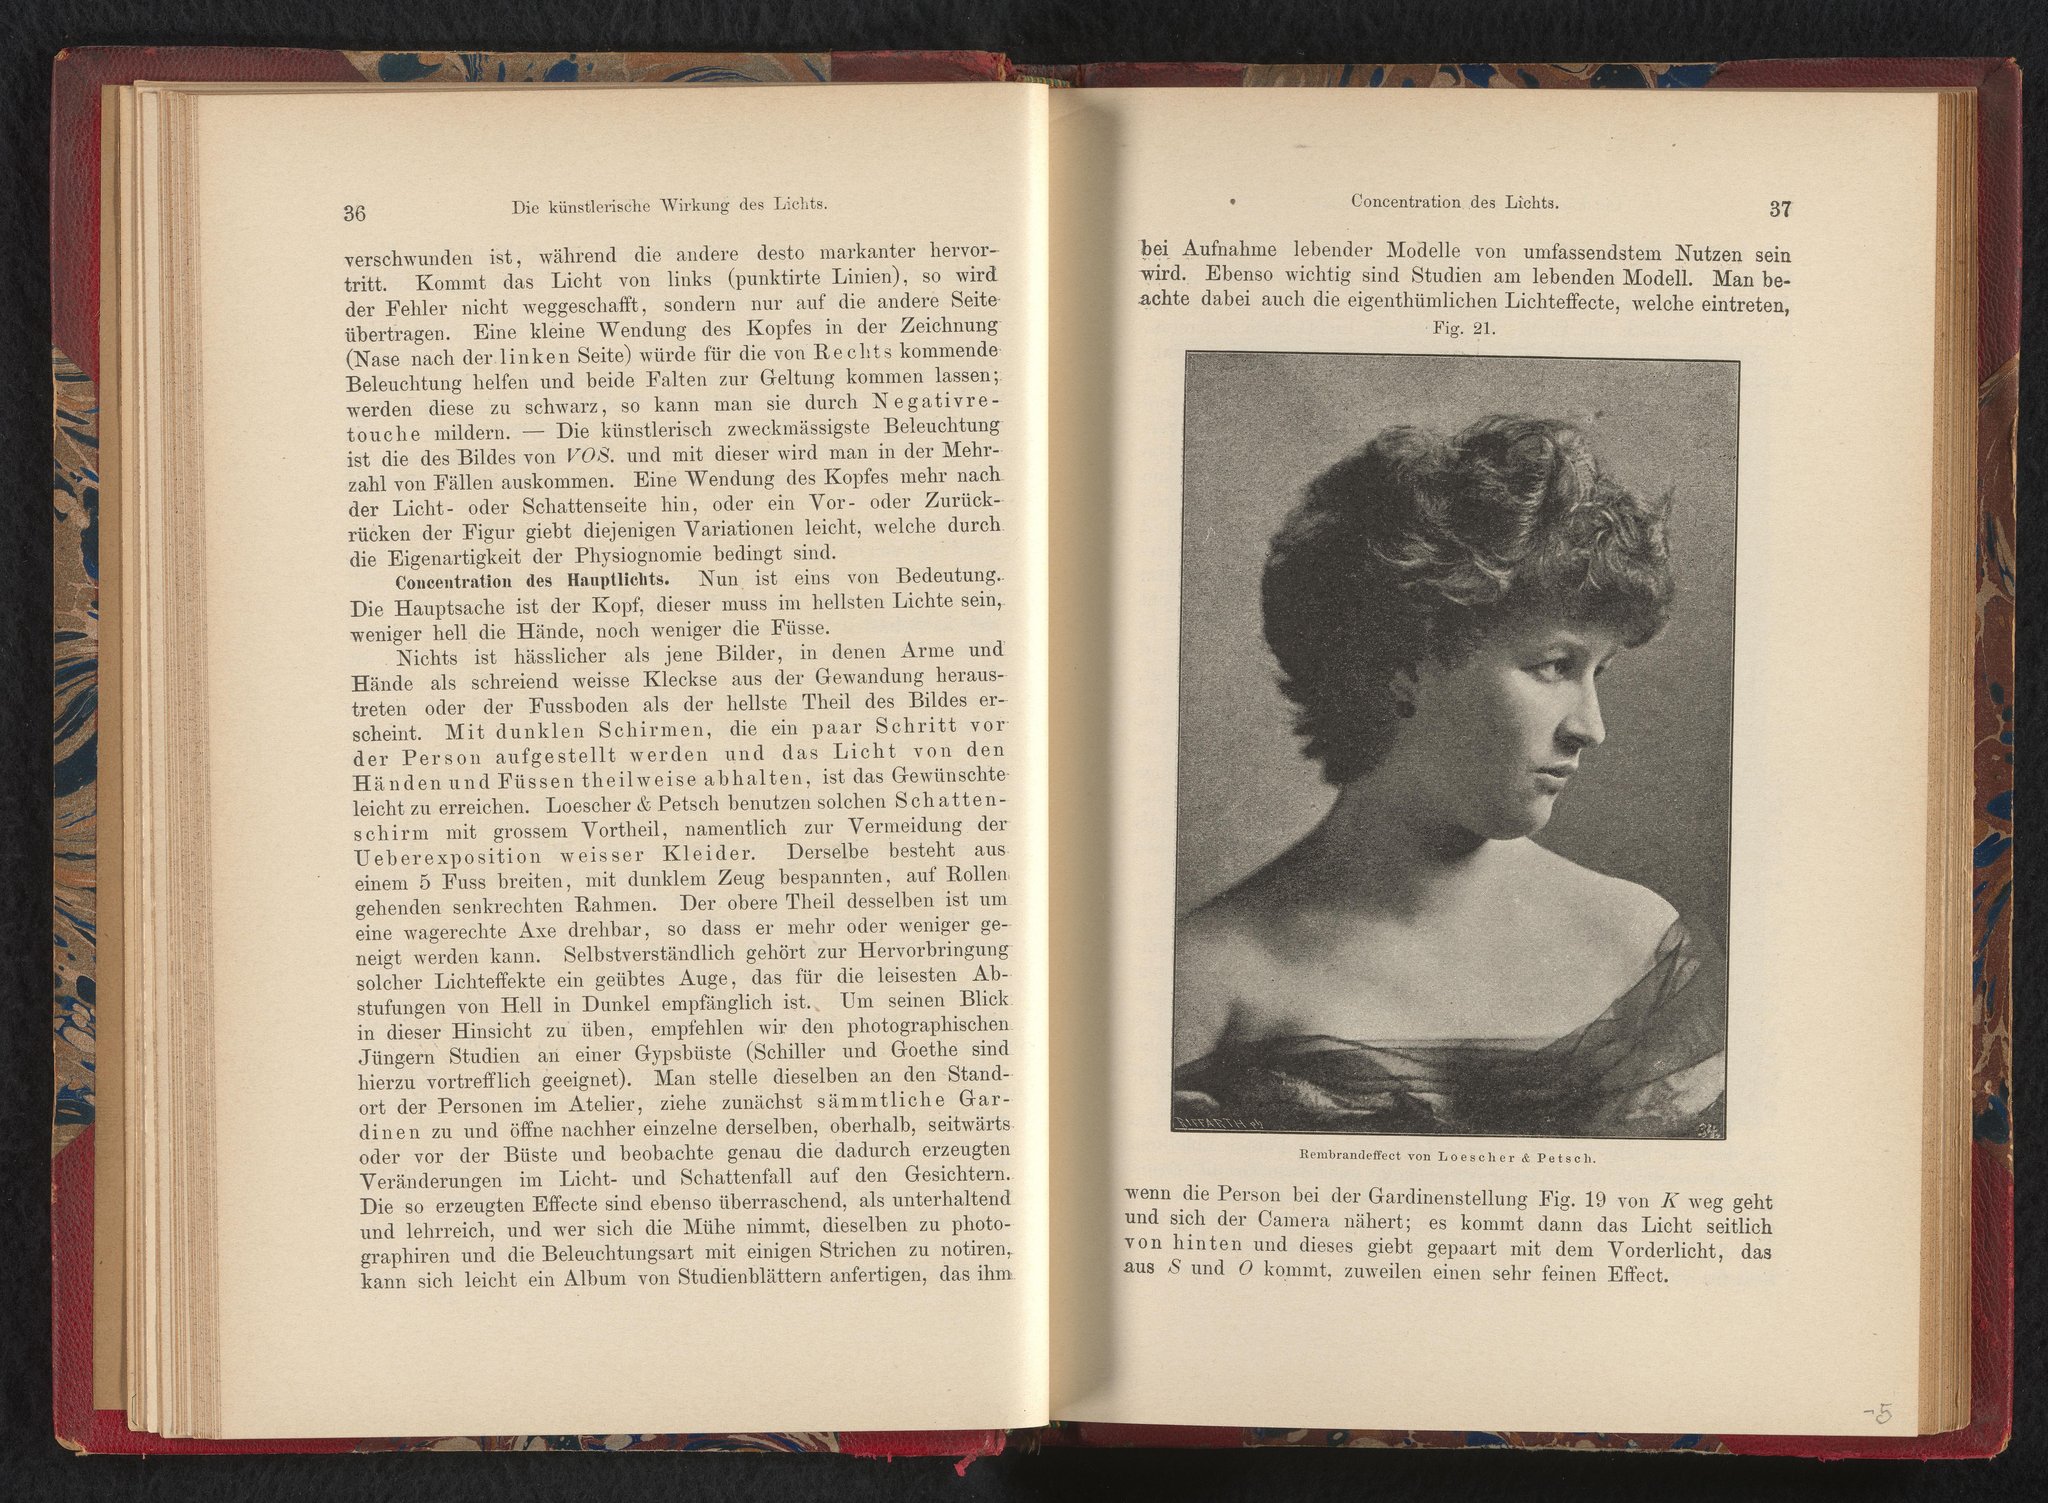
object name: page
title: Portret van een onbekende vrouw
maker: heinrich riffarth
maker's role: printer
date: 1886-1891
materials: paper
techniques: autotype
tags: anonymous historical person portrayed alone - bb - woman